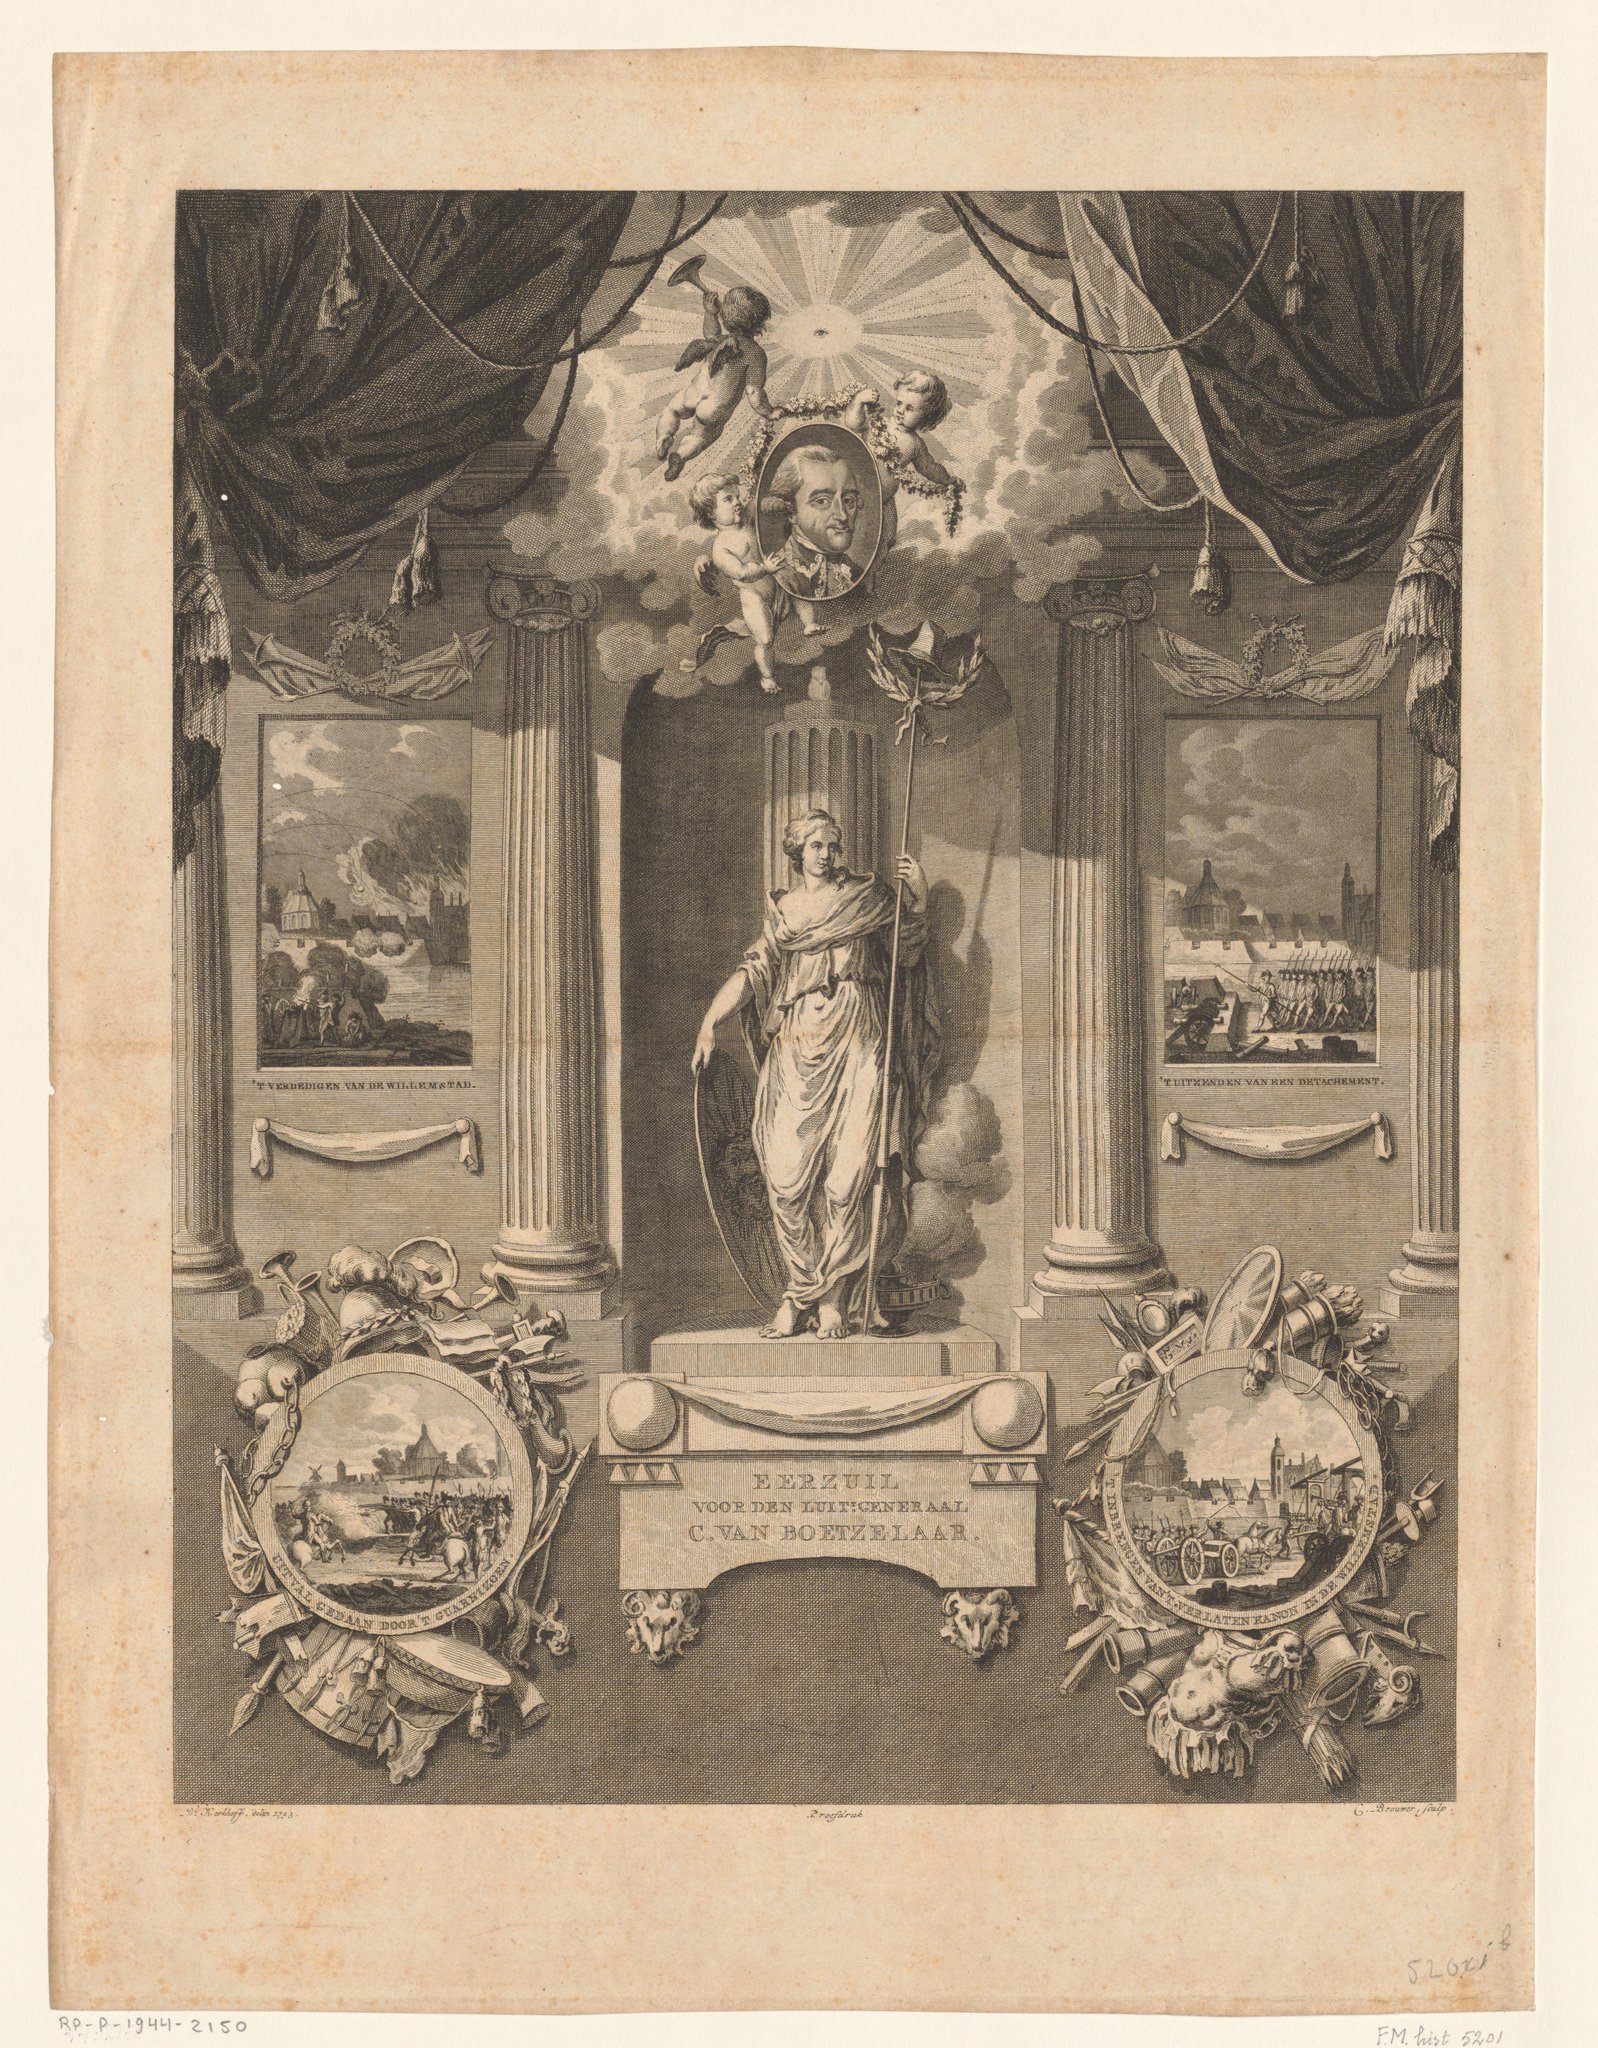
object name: print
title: Erezuil voor Carel van Boetzelaer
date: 1793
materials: paper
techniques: engraving, etching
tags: the hague, historical persons, freedom, liberty; 'libertà' (ripa), siege, cupids: 'amores', 'amoretti', 'putti'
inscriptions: collector's mark: Lugt 2228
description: In het midden een nis met een standbeeld van Vrijheid, bovenaan putti met een portret van Carel van Boetzelaer. Links en rechts vignetten met scènes van het beleg van Willemstad door de Fransen in 1793.